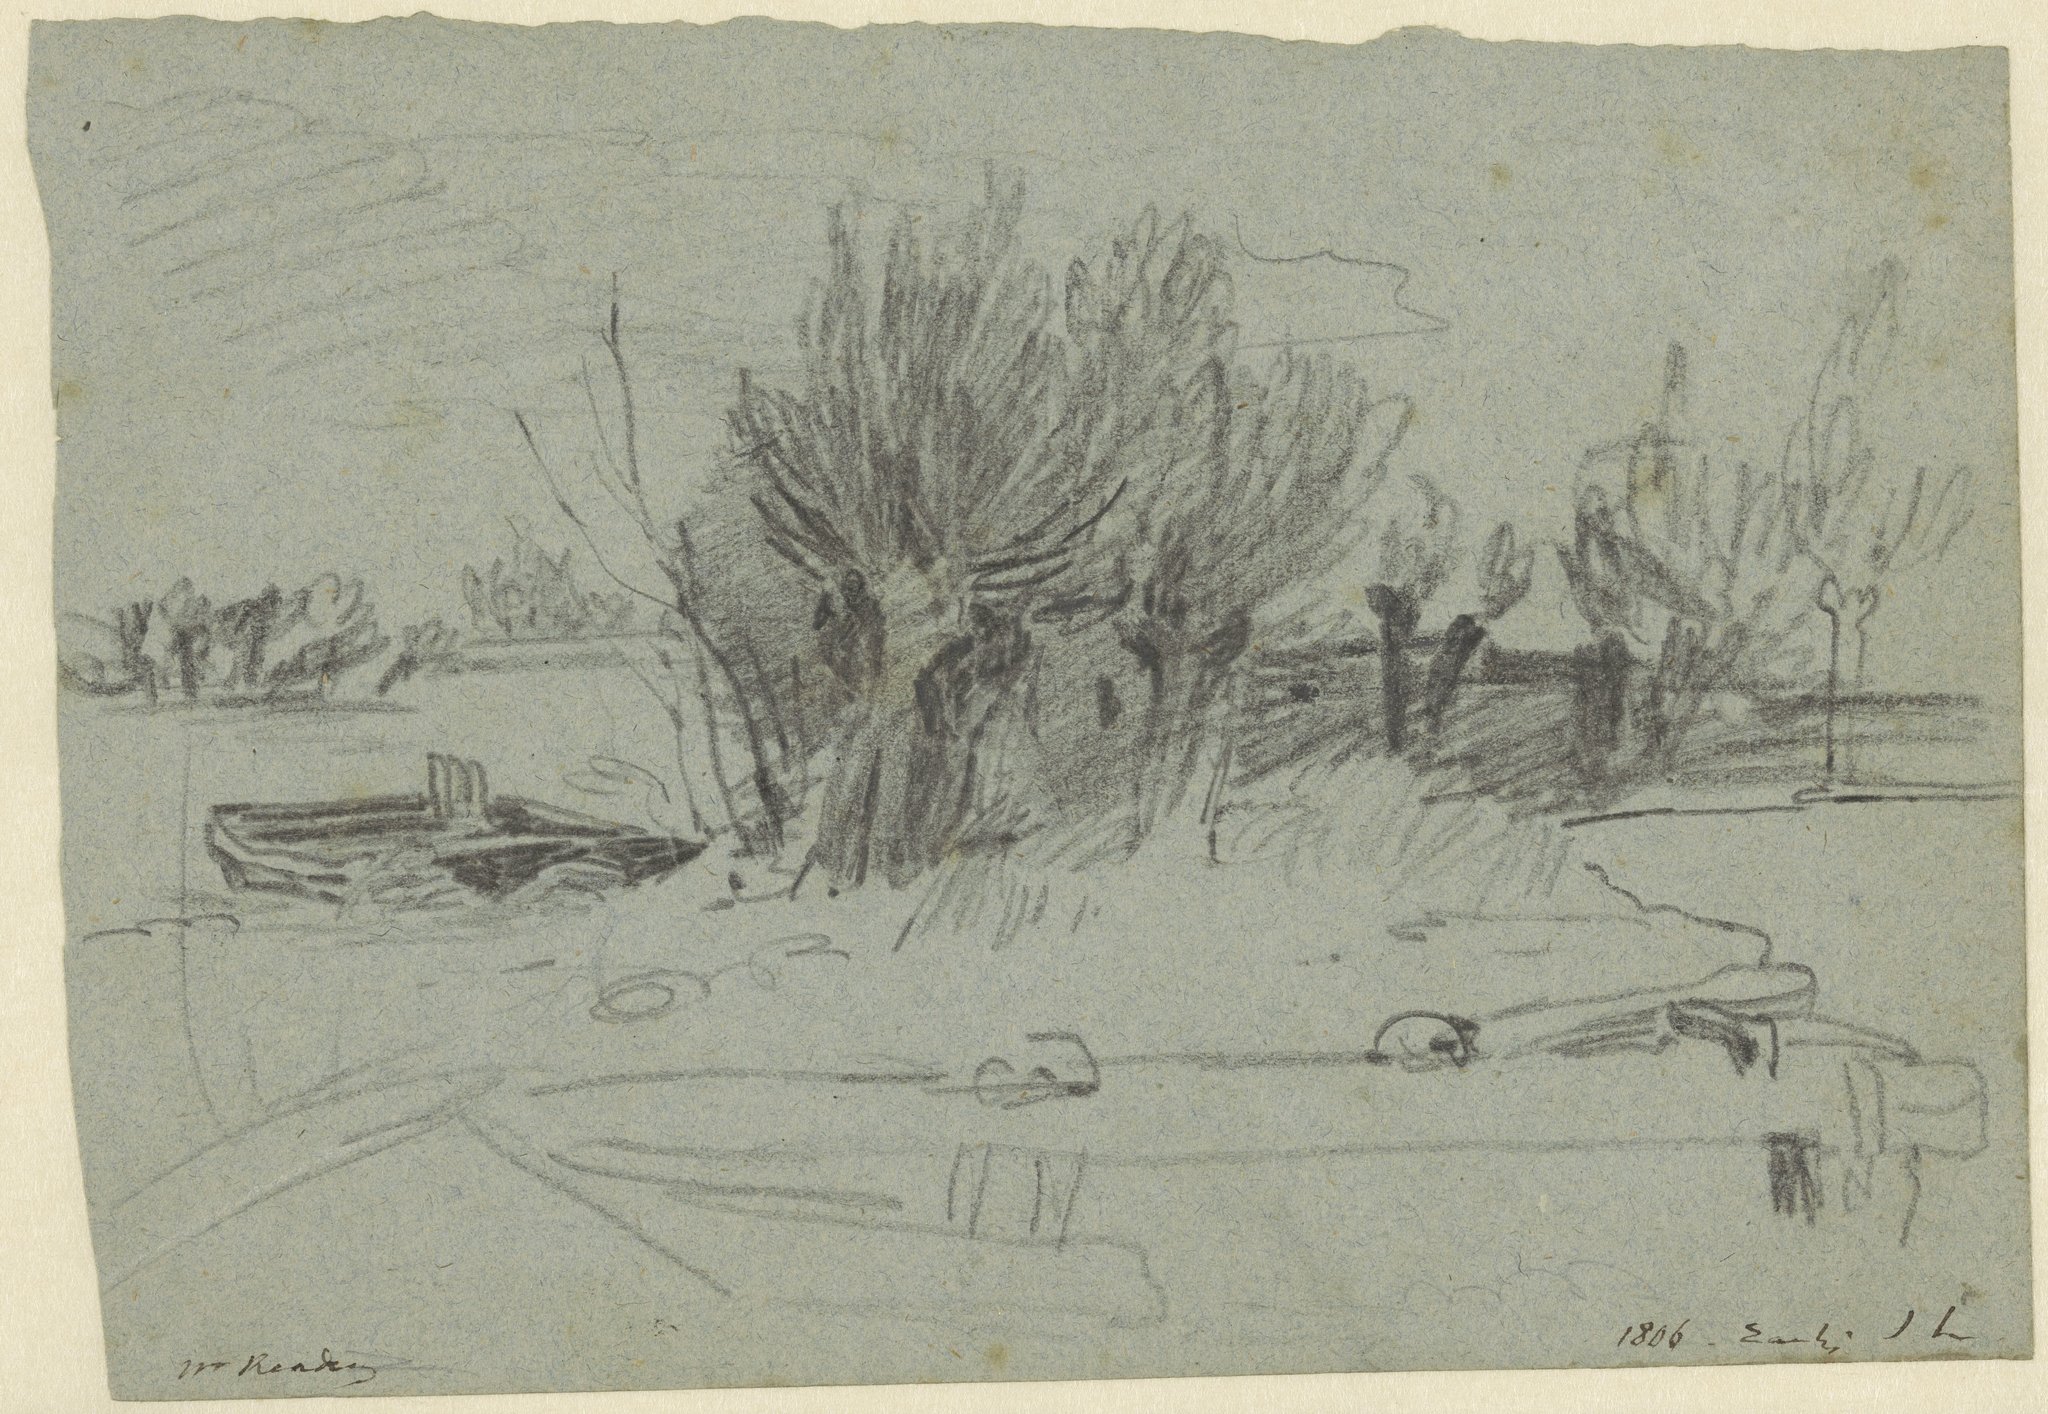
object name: drawing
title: Groep wilgen bij een rivier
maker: john linnell (ii)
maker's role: draughtsman, print maker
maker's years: 1792-1882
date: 1806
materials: chalk, paper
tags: landscapes with waters, waterscapes, seascapes (in the temperate zone) (+ landscape with figures, staffage)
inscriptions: date: ‘1806 Early’, signature: ‘JL’, signature: ‘Nr Reading’